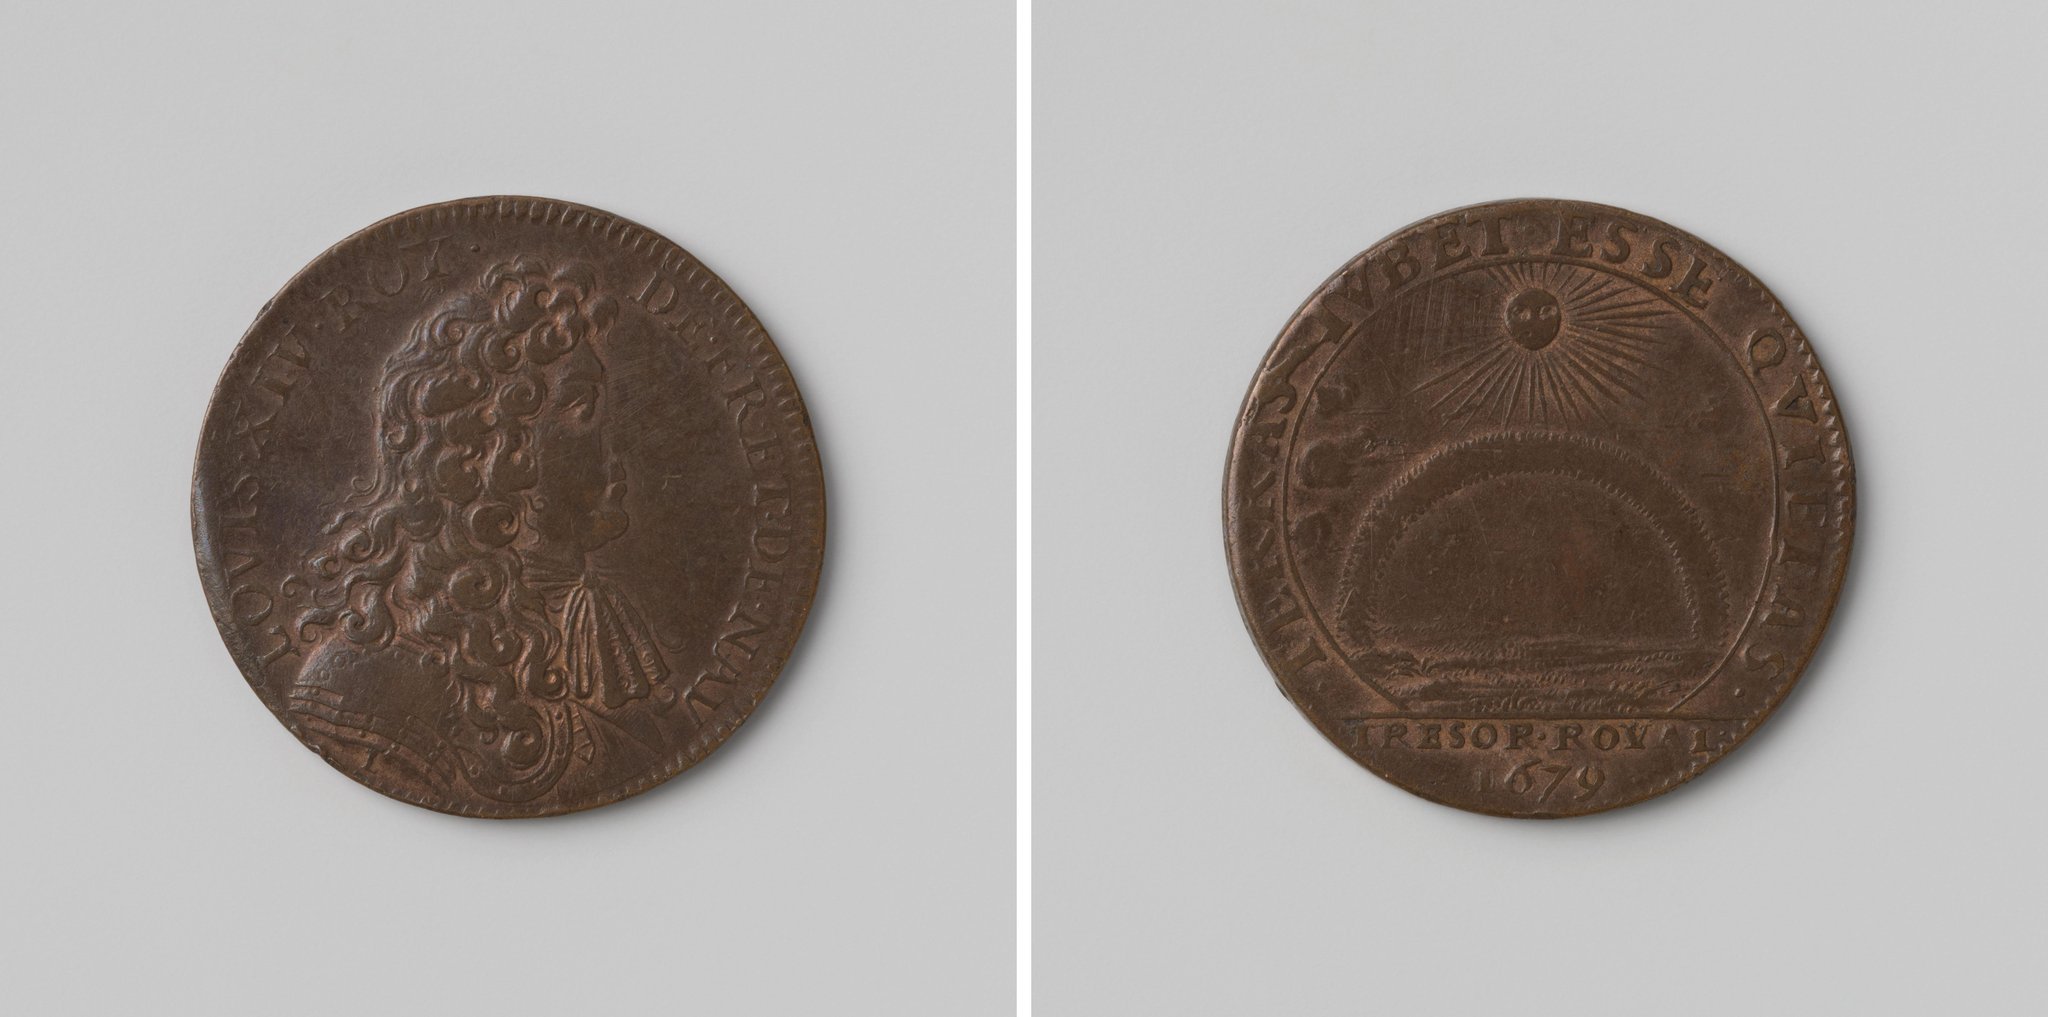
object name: medal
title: Vrede van Nijmegen, rekenpenning geslagen op last van de koninklijke schatkamer, ter ere van Lodewijk XIV, koning van Frankrijk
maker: lazarus gottlieb lauffer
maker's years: 1660-1700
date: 1679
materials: copper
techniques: striking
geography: nuremberg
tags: lodewijk xiv (koning van frankrijk), nijmegen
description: Koperen penning. Voorzijde: borststuk man binnen omschrift. Keerzijde: stralende zon boven regenboog binnen omschrift; afsnede: opschrift